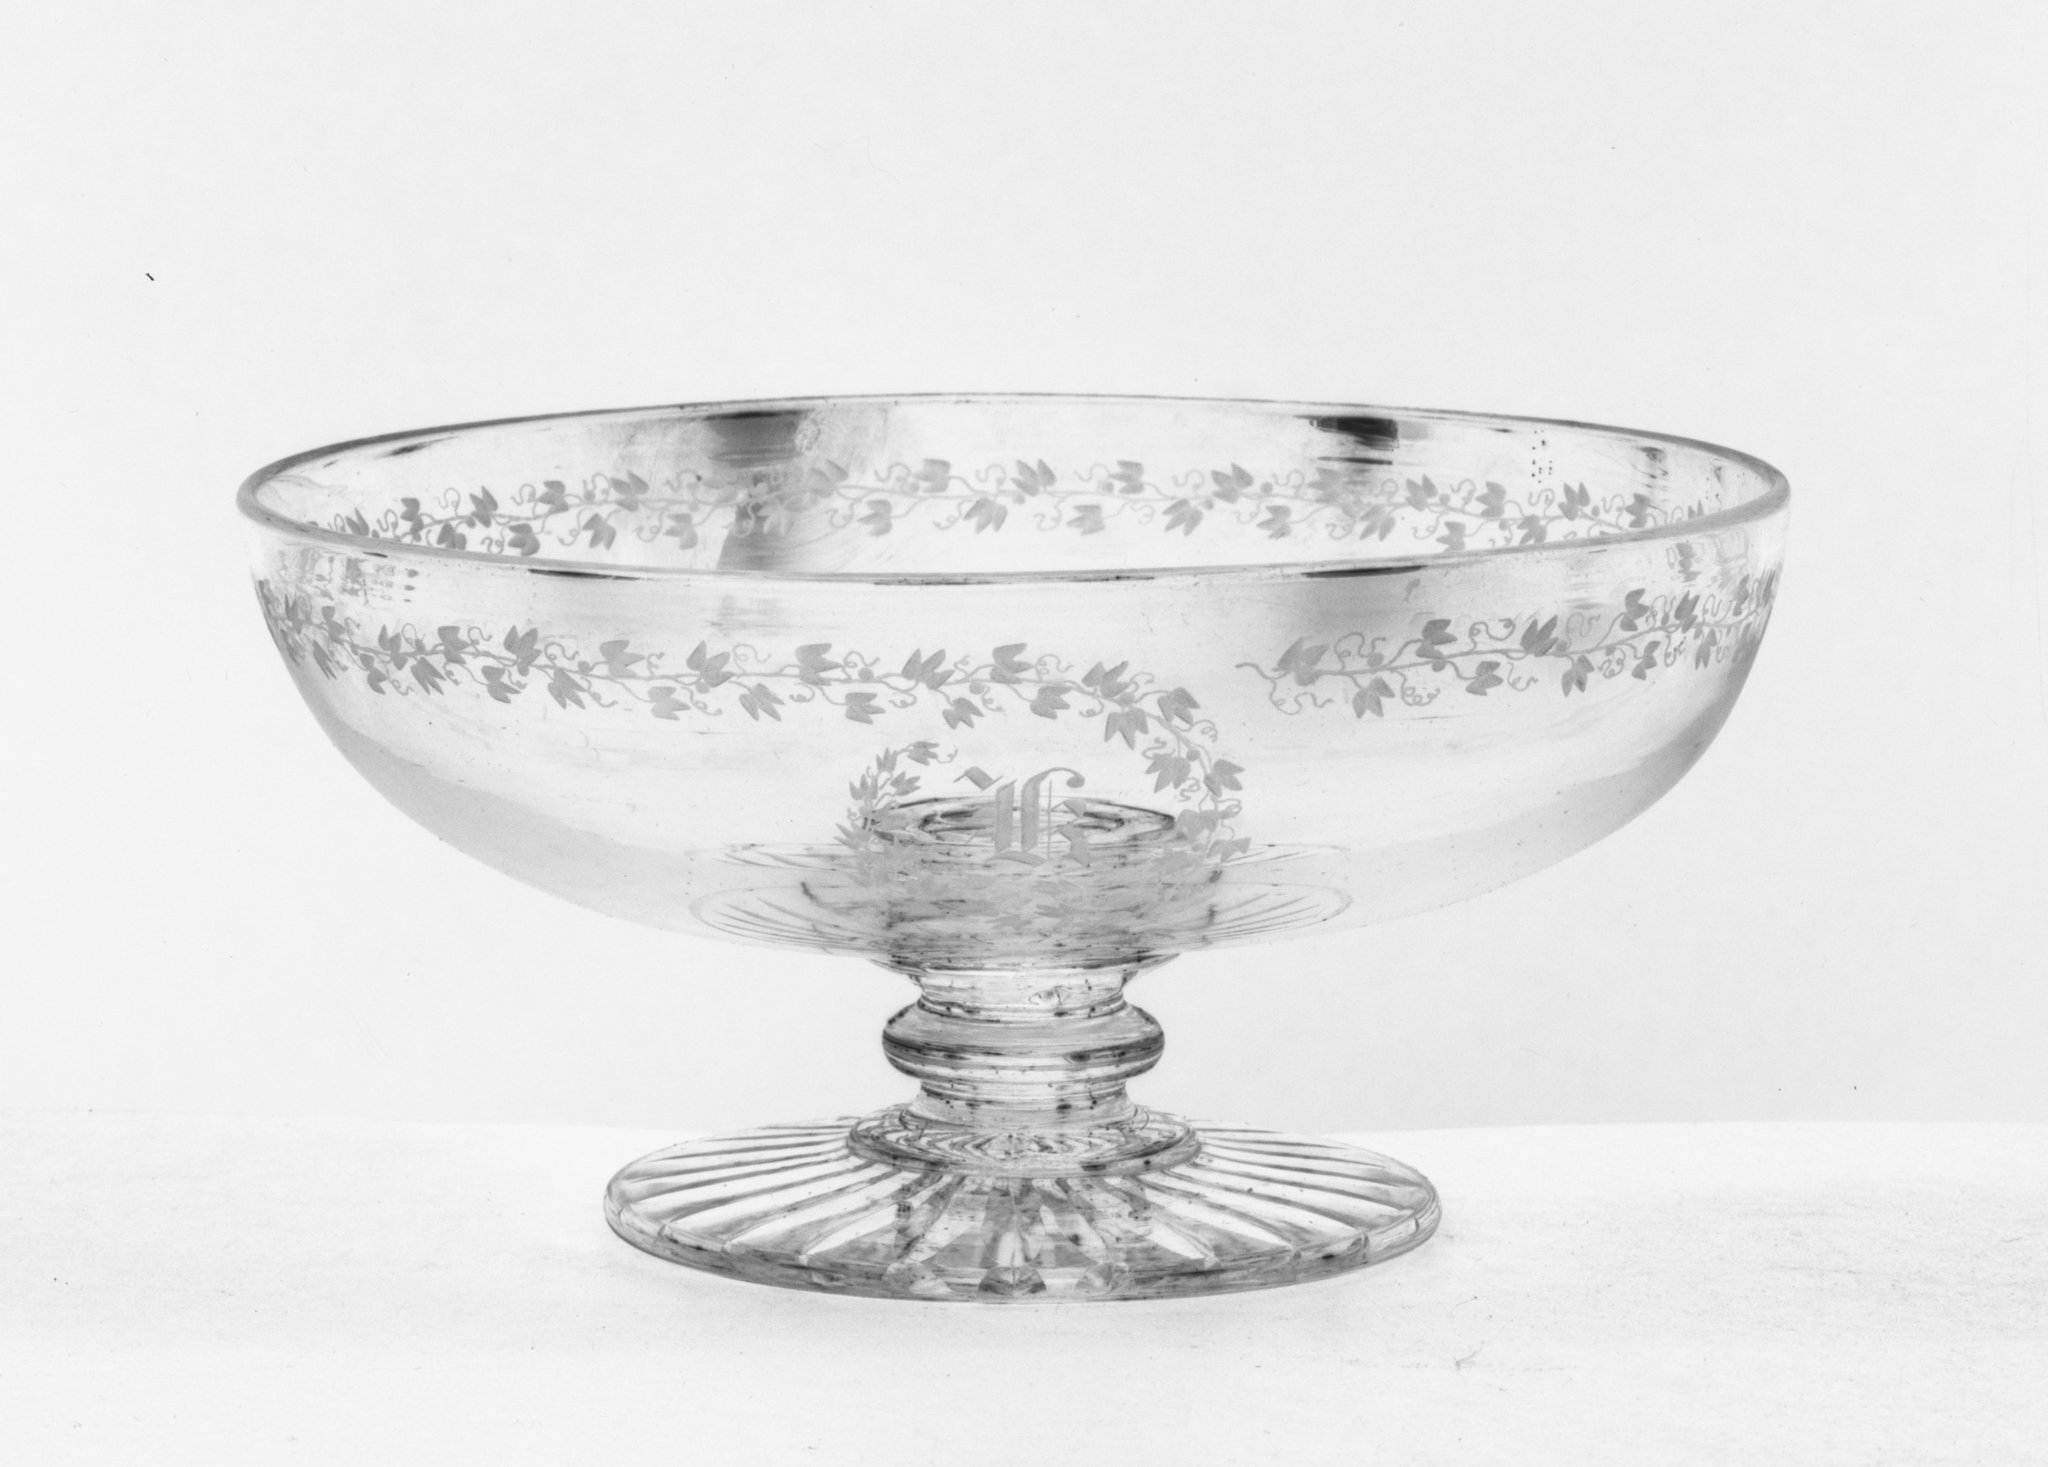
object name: berry dish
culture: american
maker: boston & sandwich glass company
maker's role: maker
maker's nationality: american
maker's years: 1825-1888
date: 1867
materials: glass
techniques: glassblowing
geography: united states